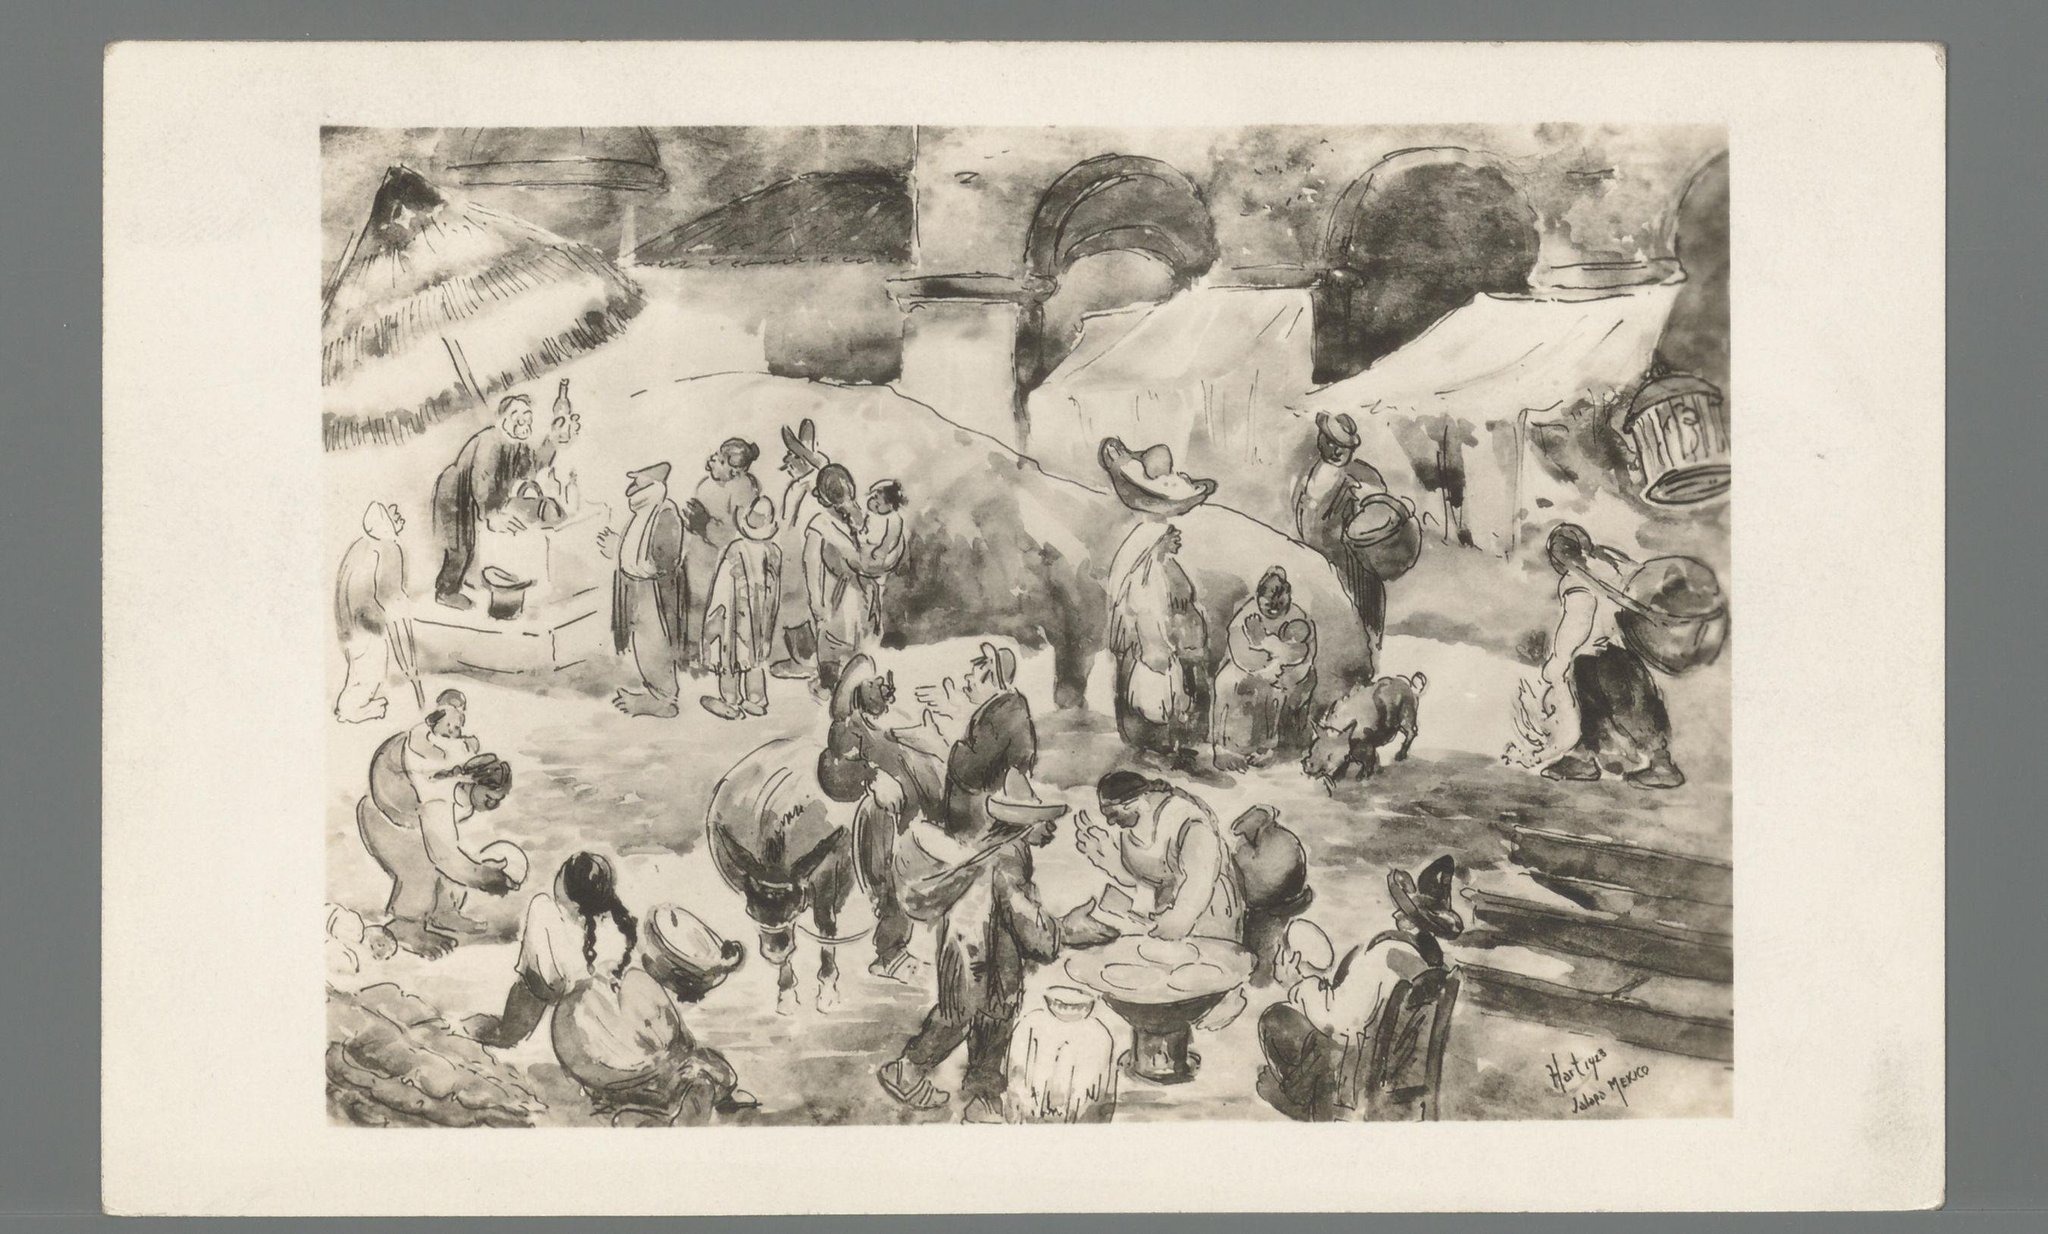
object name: ansichtkaart, prentbriefkaart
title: Market Plaza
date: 1937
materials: photographic support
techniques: photography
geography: cleveland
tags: stall, booth (~ market), square, place, circus, etc. (+ city(-scape) with figures, staffage)